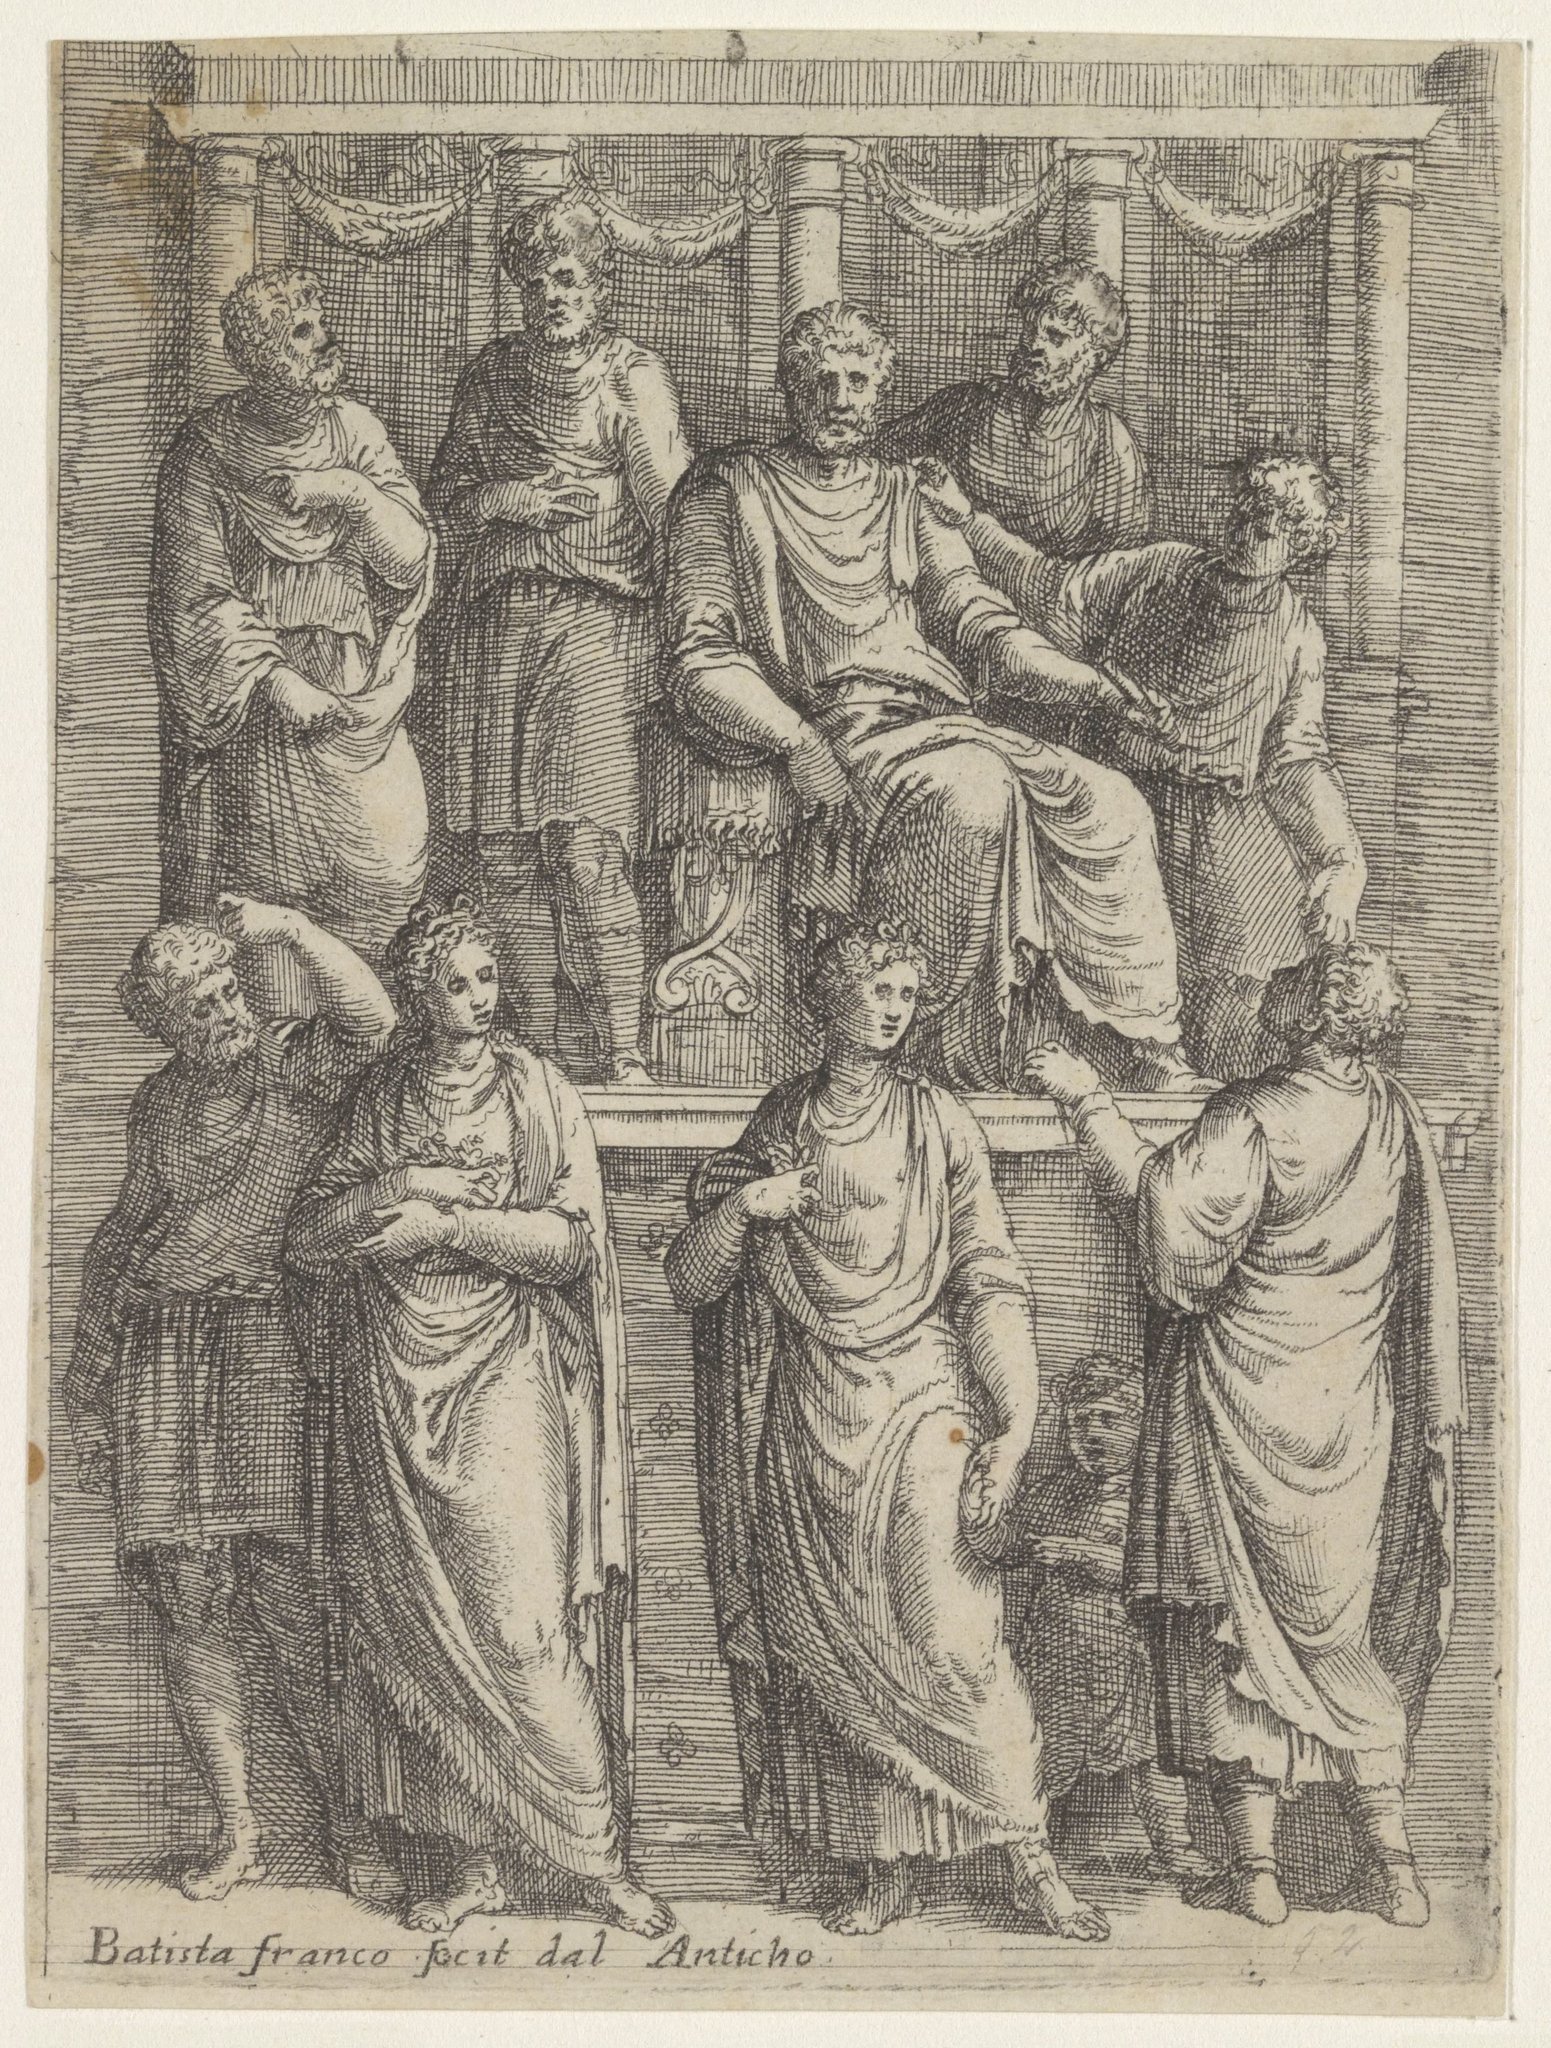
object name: print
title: Geschiedenis van Keizer Trajanus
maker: battista franco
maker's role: draughtsman, painter, print maker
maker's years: 1510-1561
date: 1520-1561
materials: paper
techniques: etching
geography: italy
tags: administration of justice, trial, magistracy, judges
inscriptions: collector's mark: Lugt 2641b, collector's mark: Lugt 2228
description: Prent uit een reeks van 6 prenten over de geschiedenis van Keizer Trajanus. De zes prenten werden origineel van één plaat gedrukt en daarna versneden. Naar een gebeeldhouwd reliëf op de Boog van Constantijn te Rome.